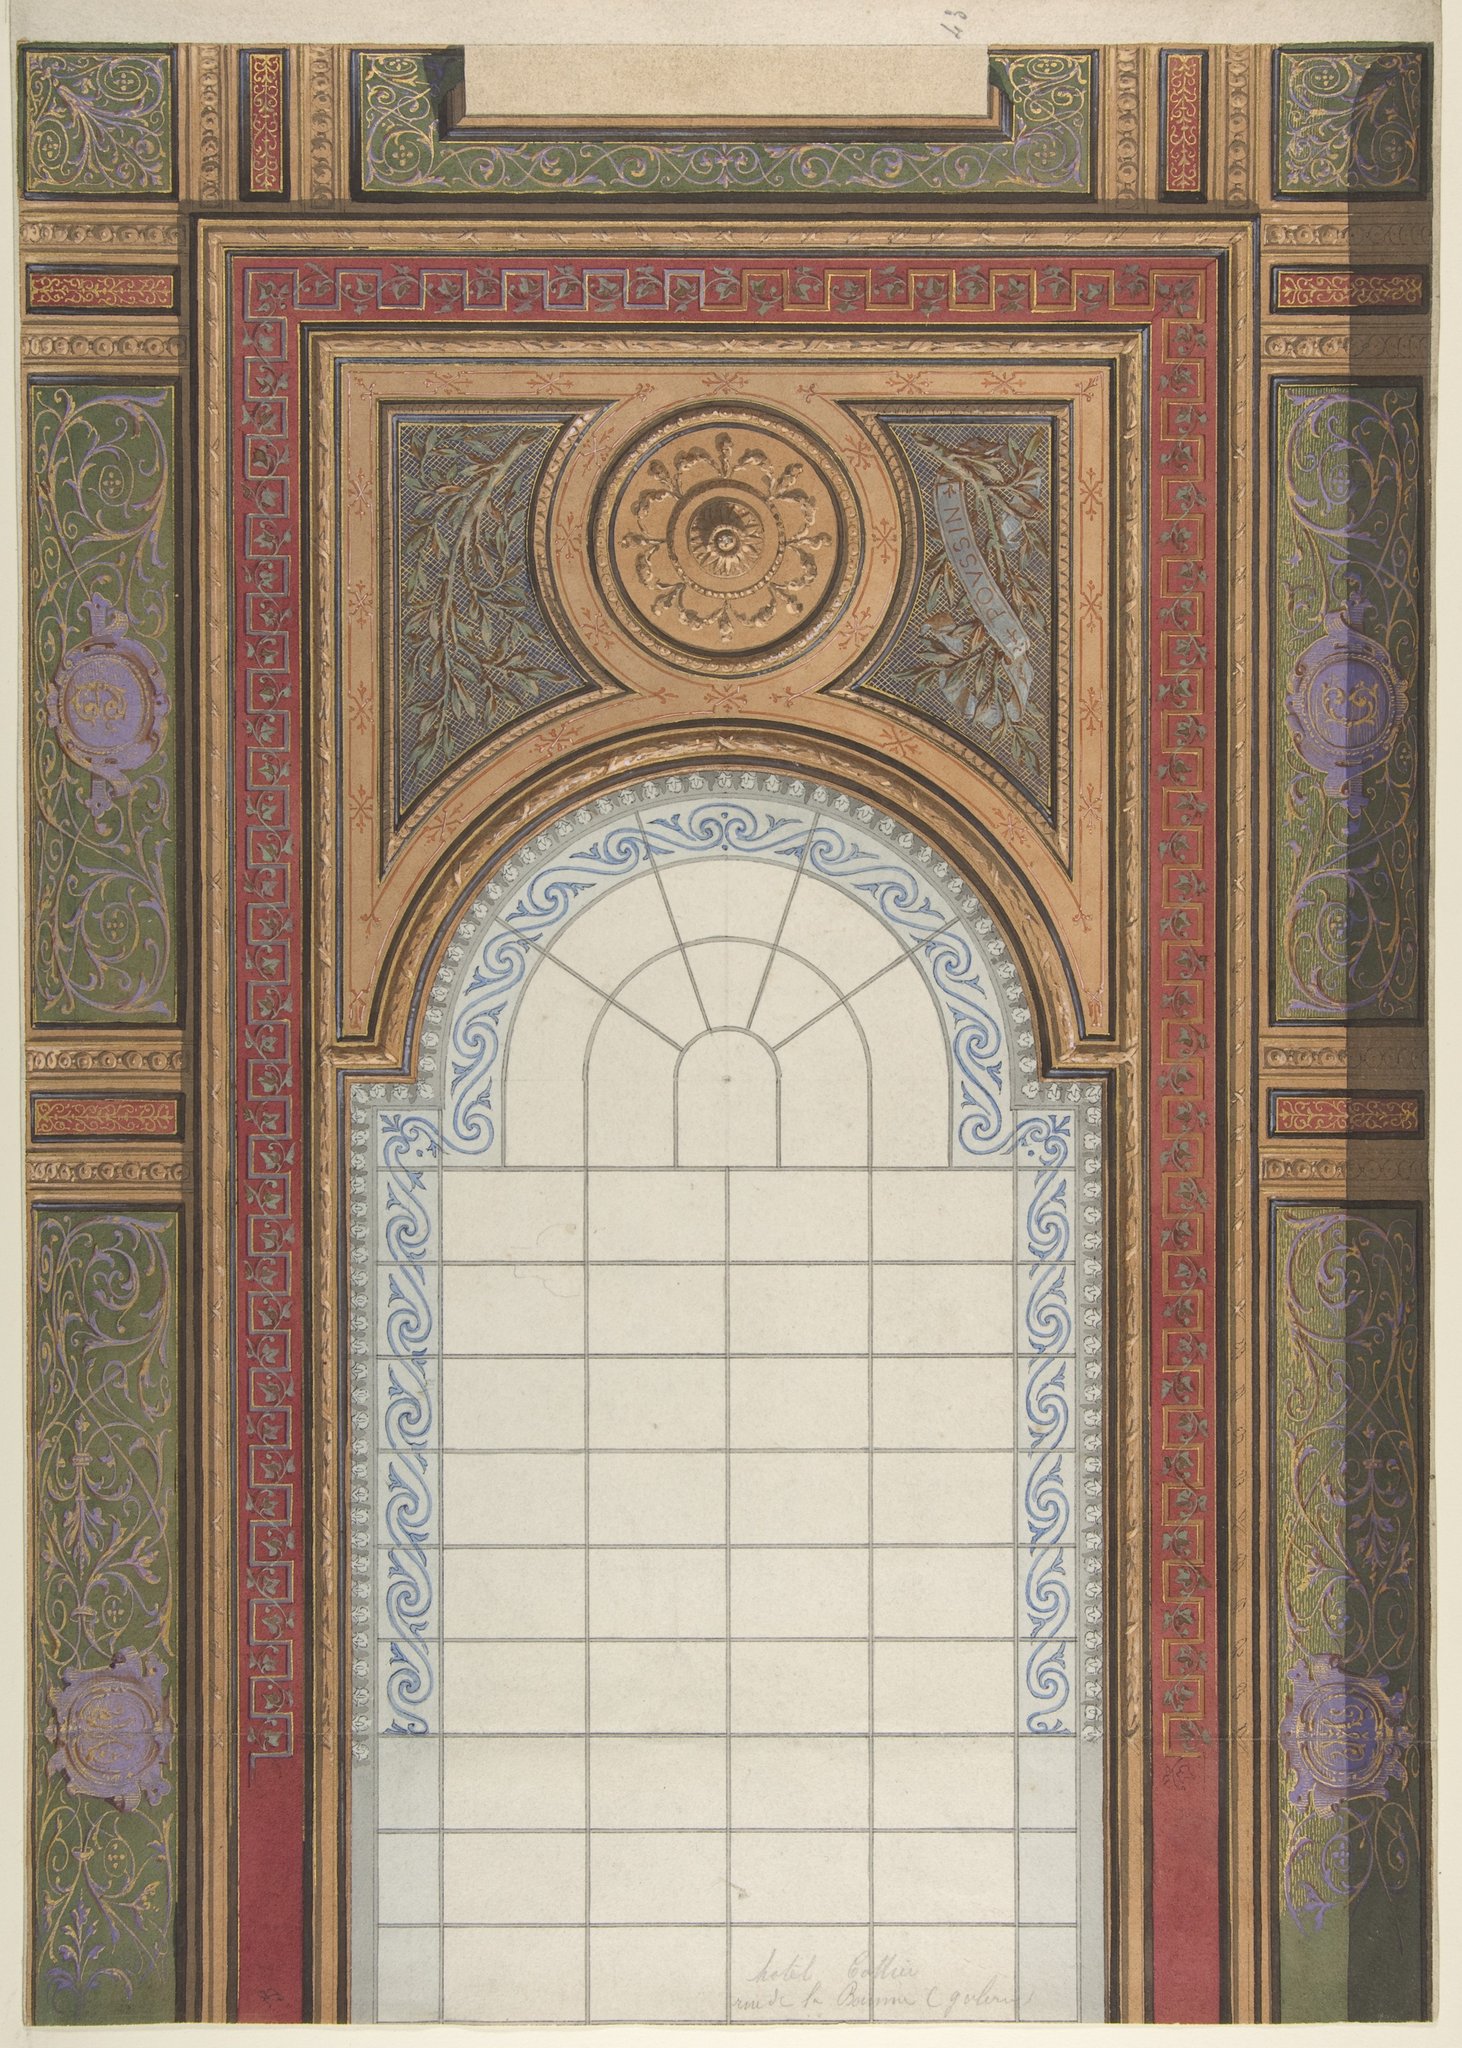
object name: drawing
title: Gallery Ceiling Design, Hôtel Cottier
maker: jules-edmond-charles lachaise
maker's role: artist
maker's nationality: french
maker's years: 1897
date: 1867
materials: gilt, graphite, ink, watercolor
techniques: brush, pen, wash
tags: ceilings